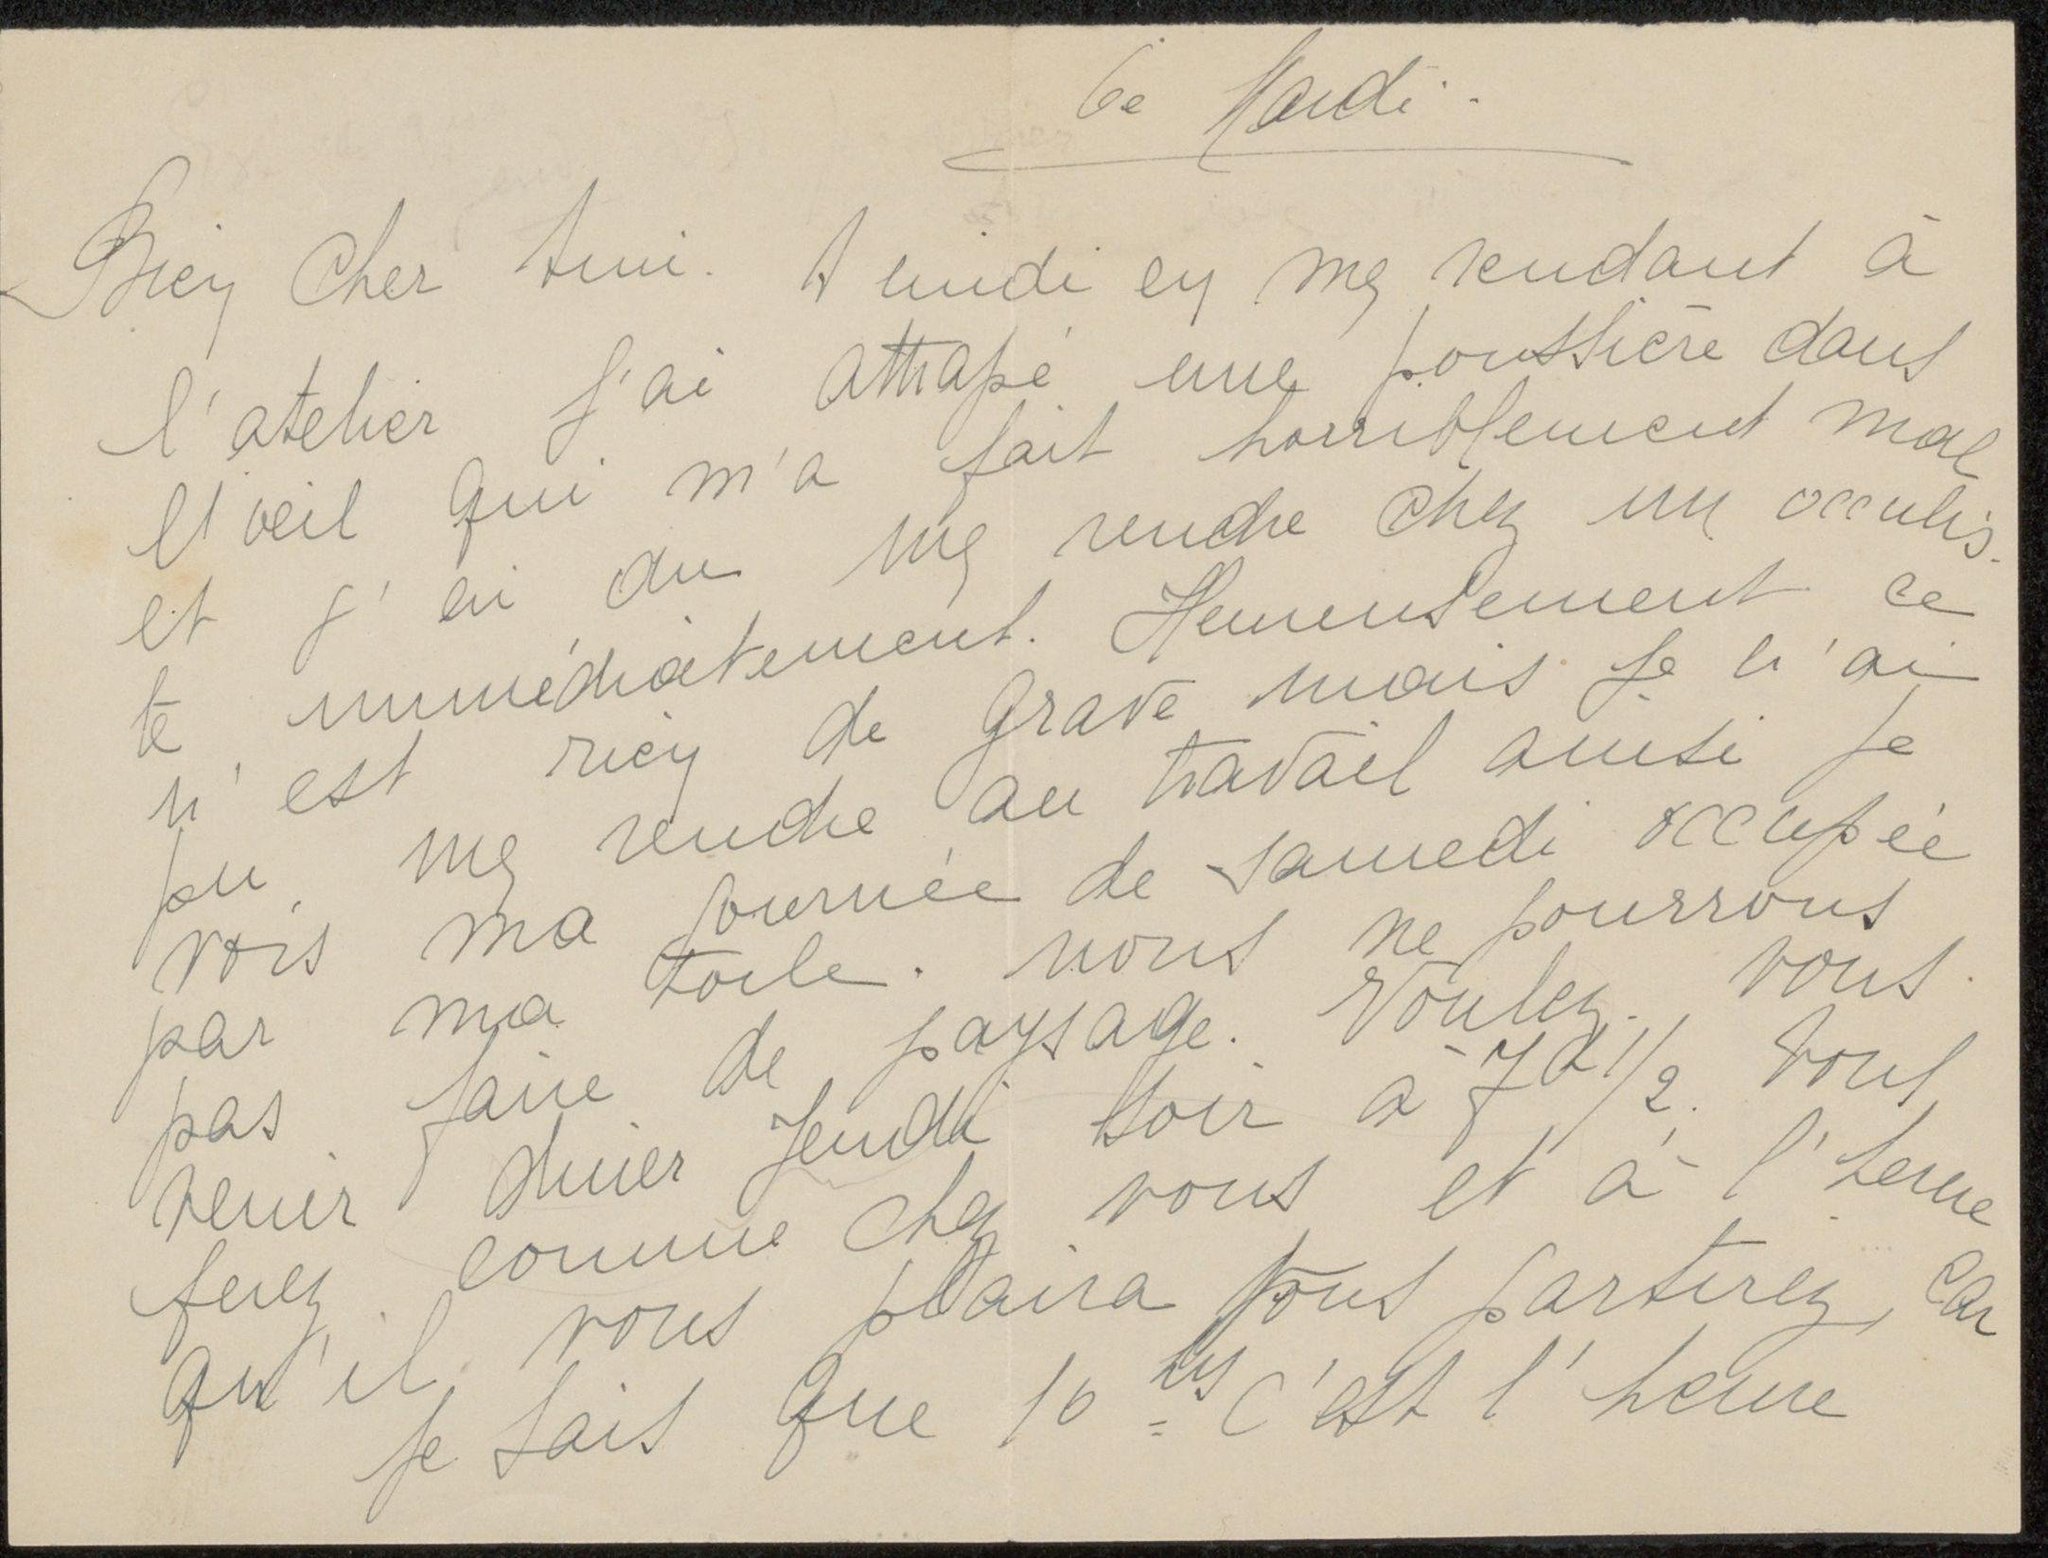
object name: letter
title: Brief aan Philip Zilcken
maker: rose imel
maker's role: draughtsman, painter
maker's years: 1901-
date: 1911-1930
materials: ink, paper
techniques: pen, writing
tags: the hague, painter, draughtsman, philip zilcken, painting (including book-illumination, miniature-painting), workshop, studio of the artist (in general)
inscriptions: collector's mark: ‘RPK’